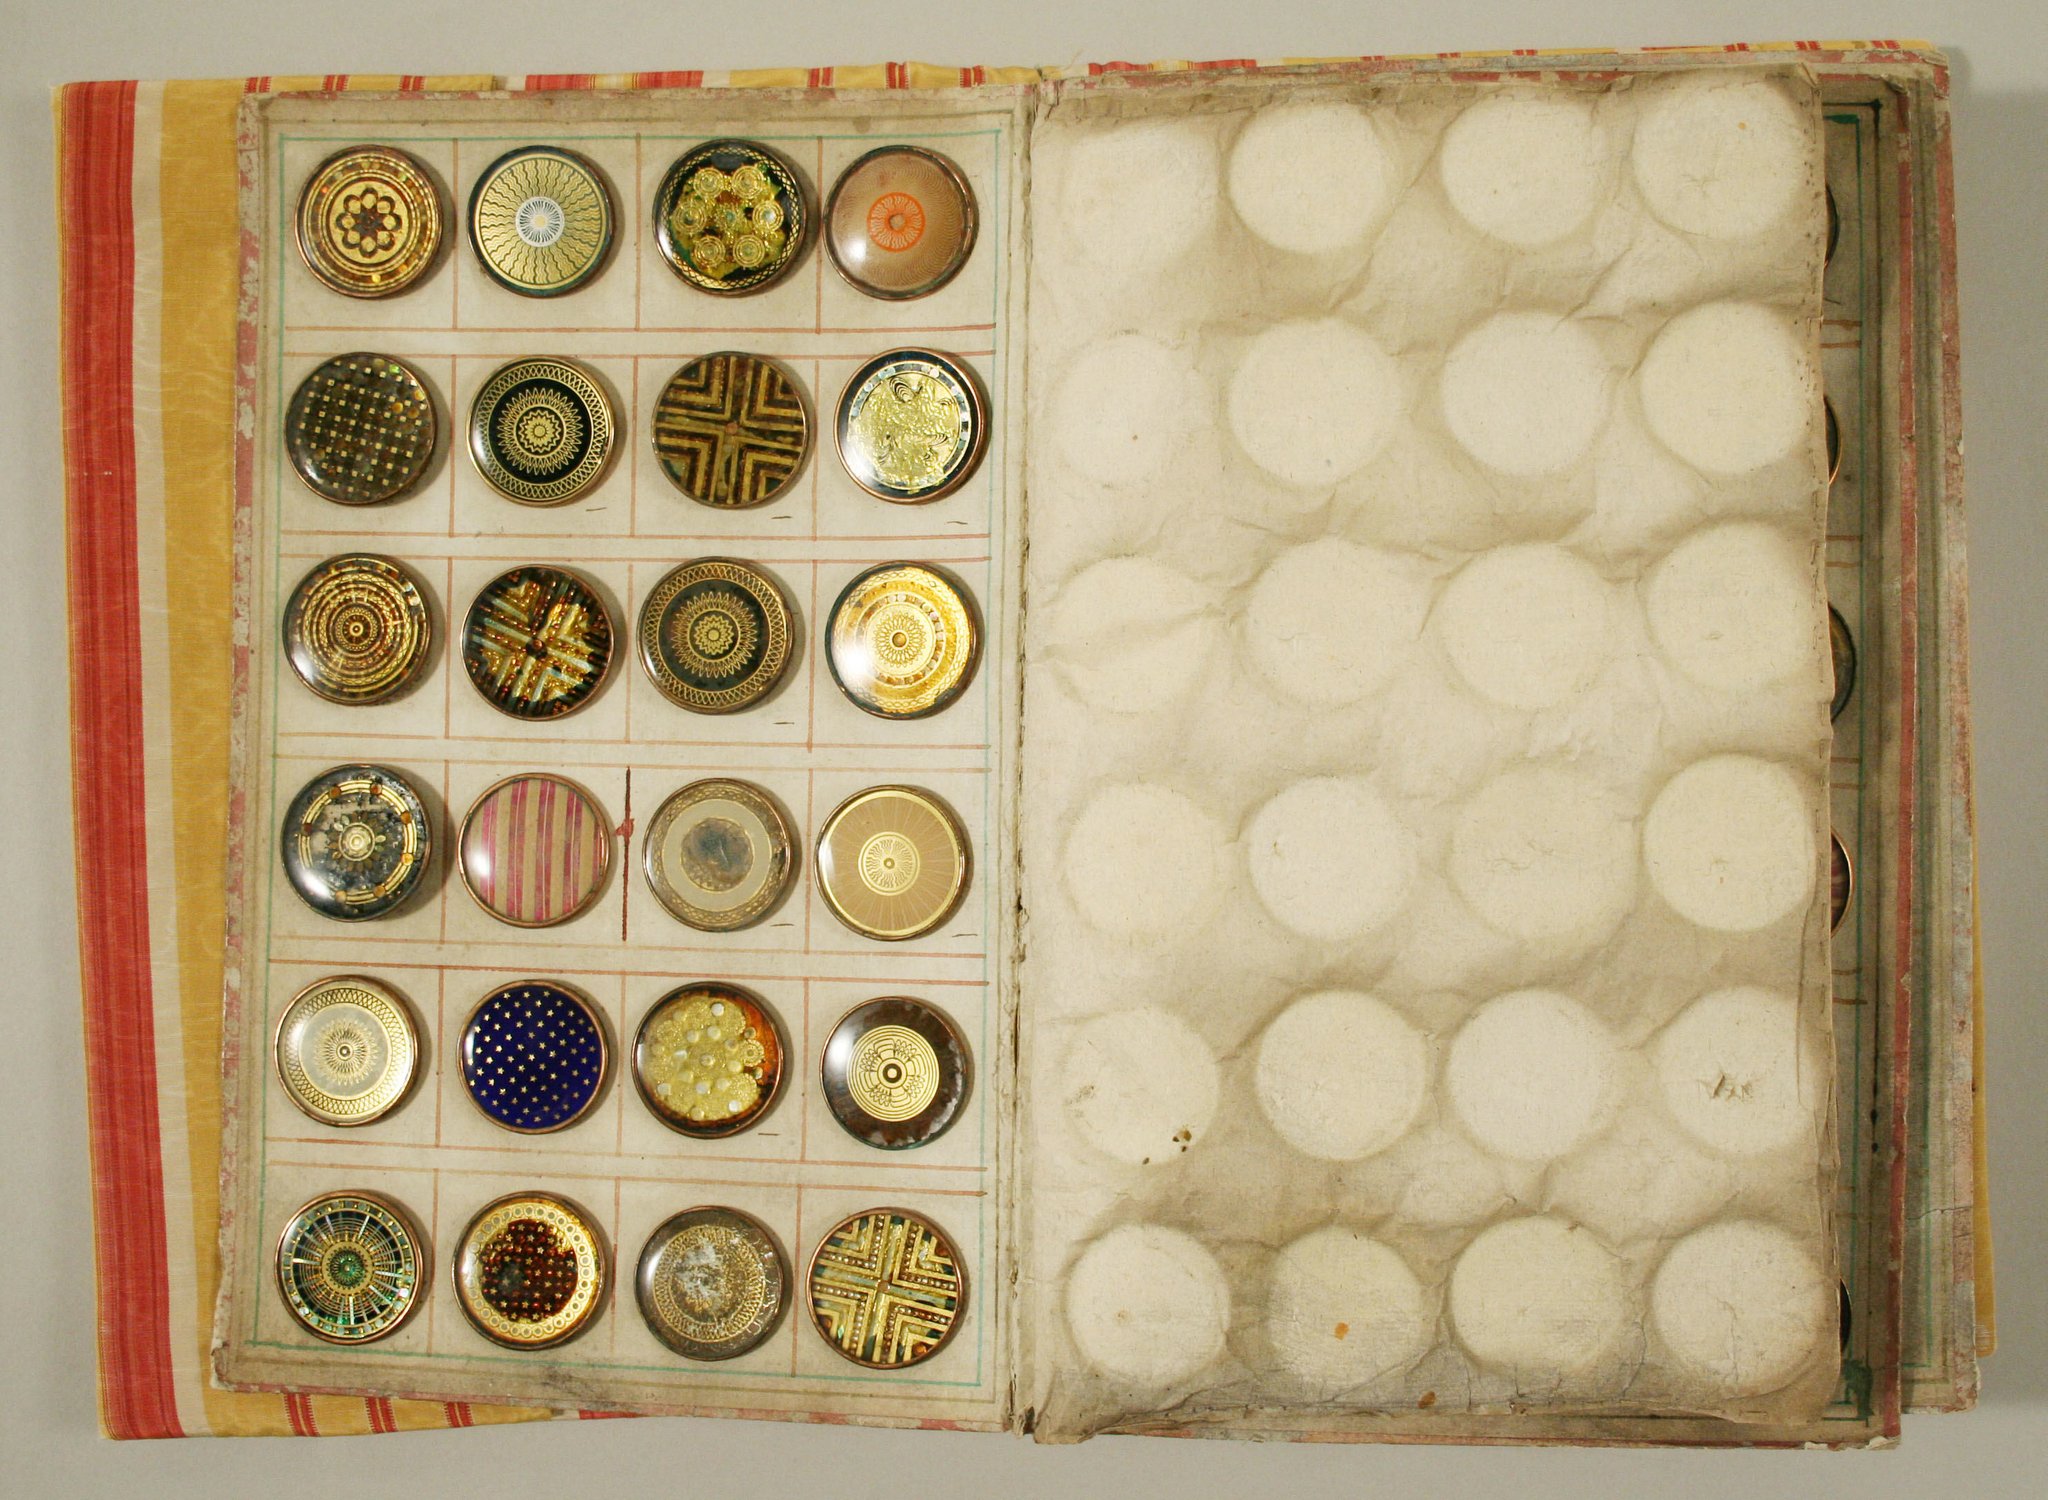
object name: button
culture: french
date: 1790